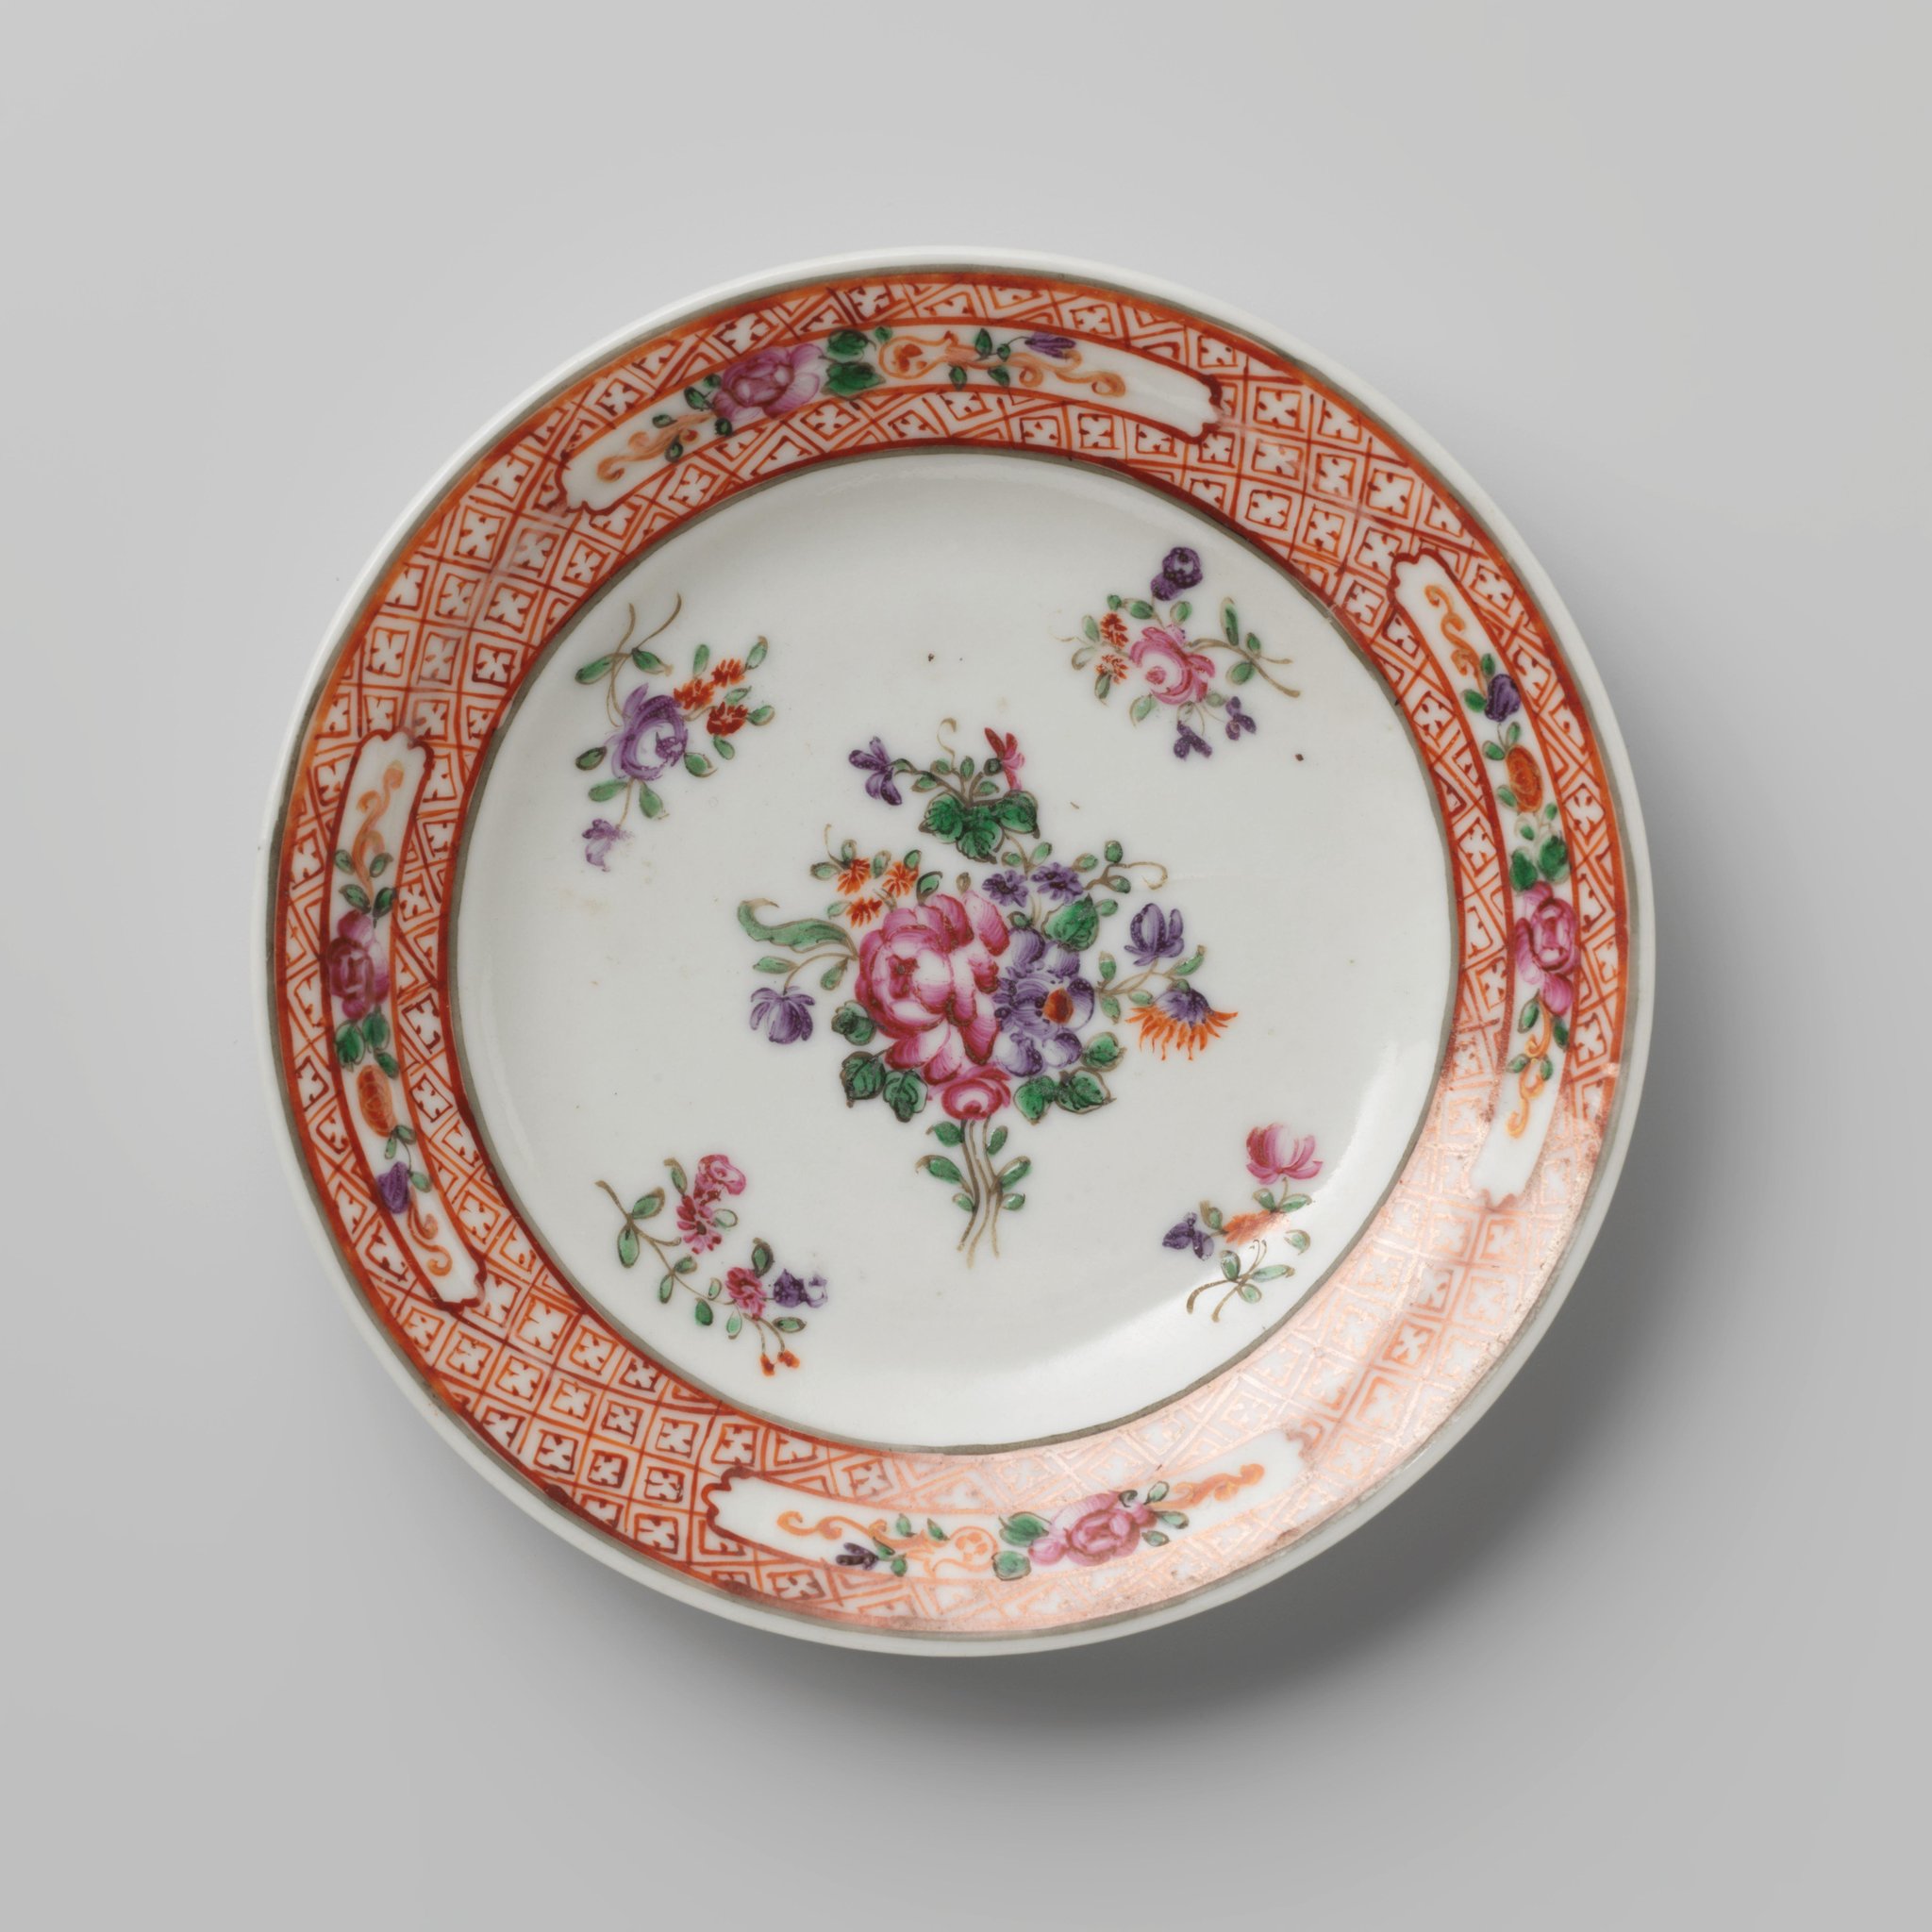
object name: platter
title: Saucer with bouquets and floral scrolls on a diaper-patters ground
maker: Anonymous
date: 1775-1799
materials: glaze, gold, paint, porcelain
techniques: firing, gilding, turning, vitrification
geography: china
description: Schotel van porselein, beschilderd op het glazuur in rood, roze, groen, zwart en goud. Op het plat van de schotel een boeket met verschillende bloemen, omgeven door vier kleinere boeketten; de rand met bloemranken in langwerpige cartouches uitgespaard in een achtergrond van servetwerk. Famille rose.